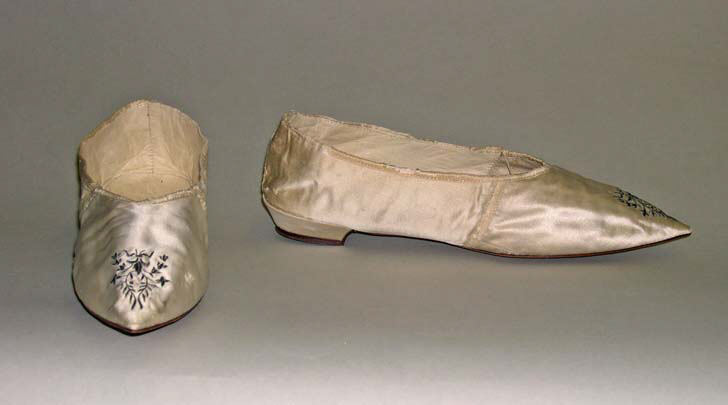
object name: slipper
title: Slippers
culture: american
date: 1795-1800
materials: leather, silk